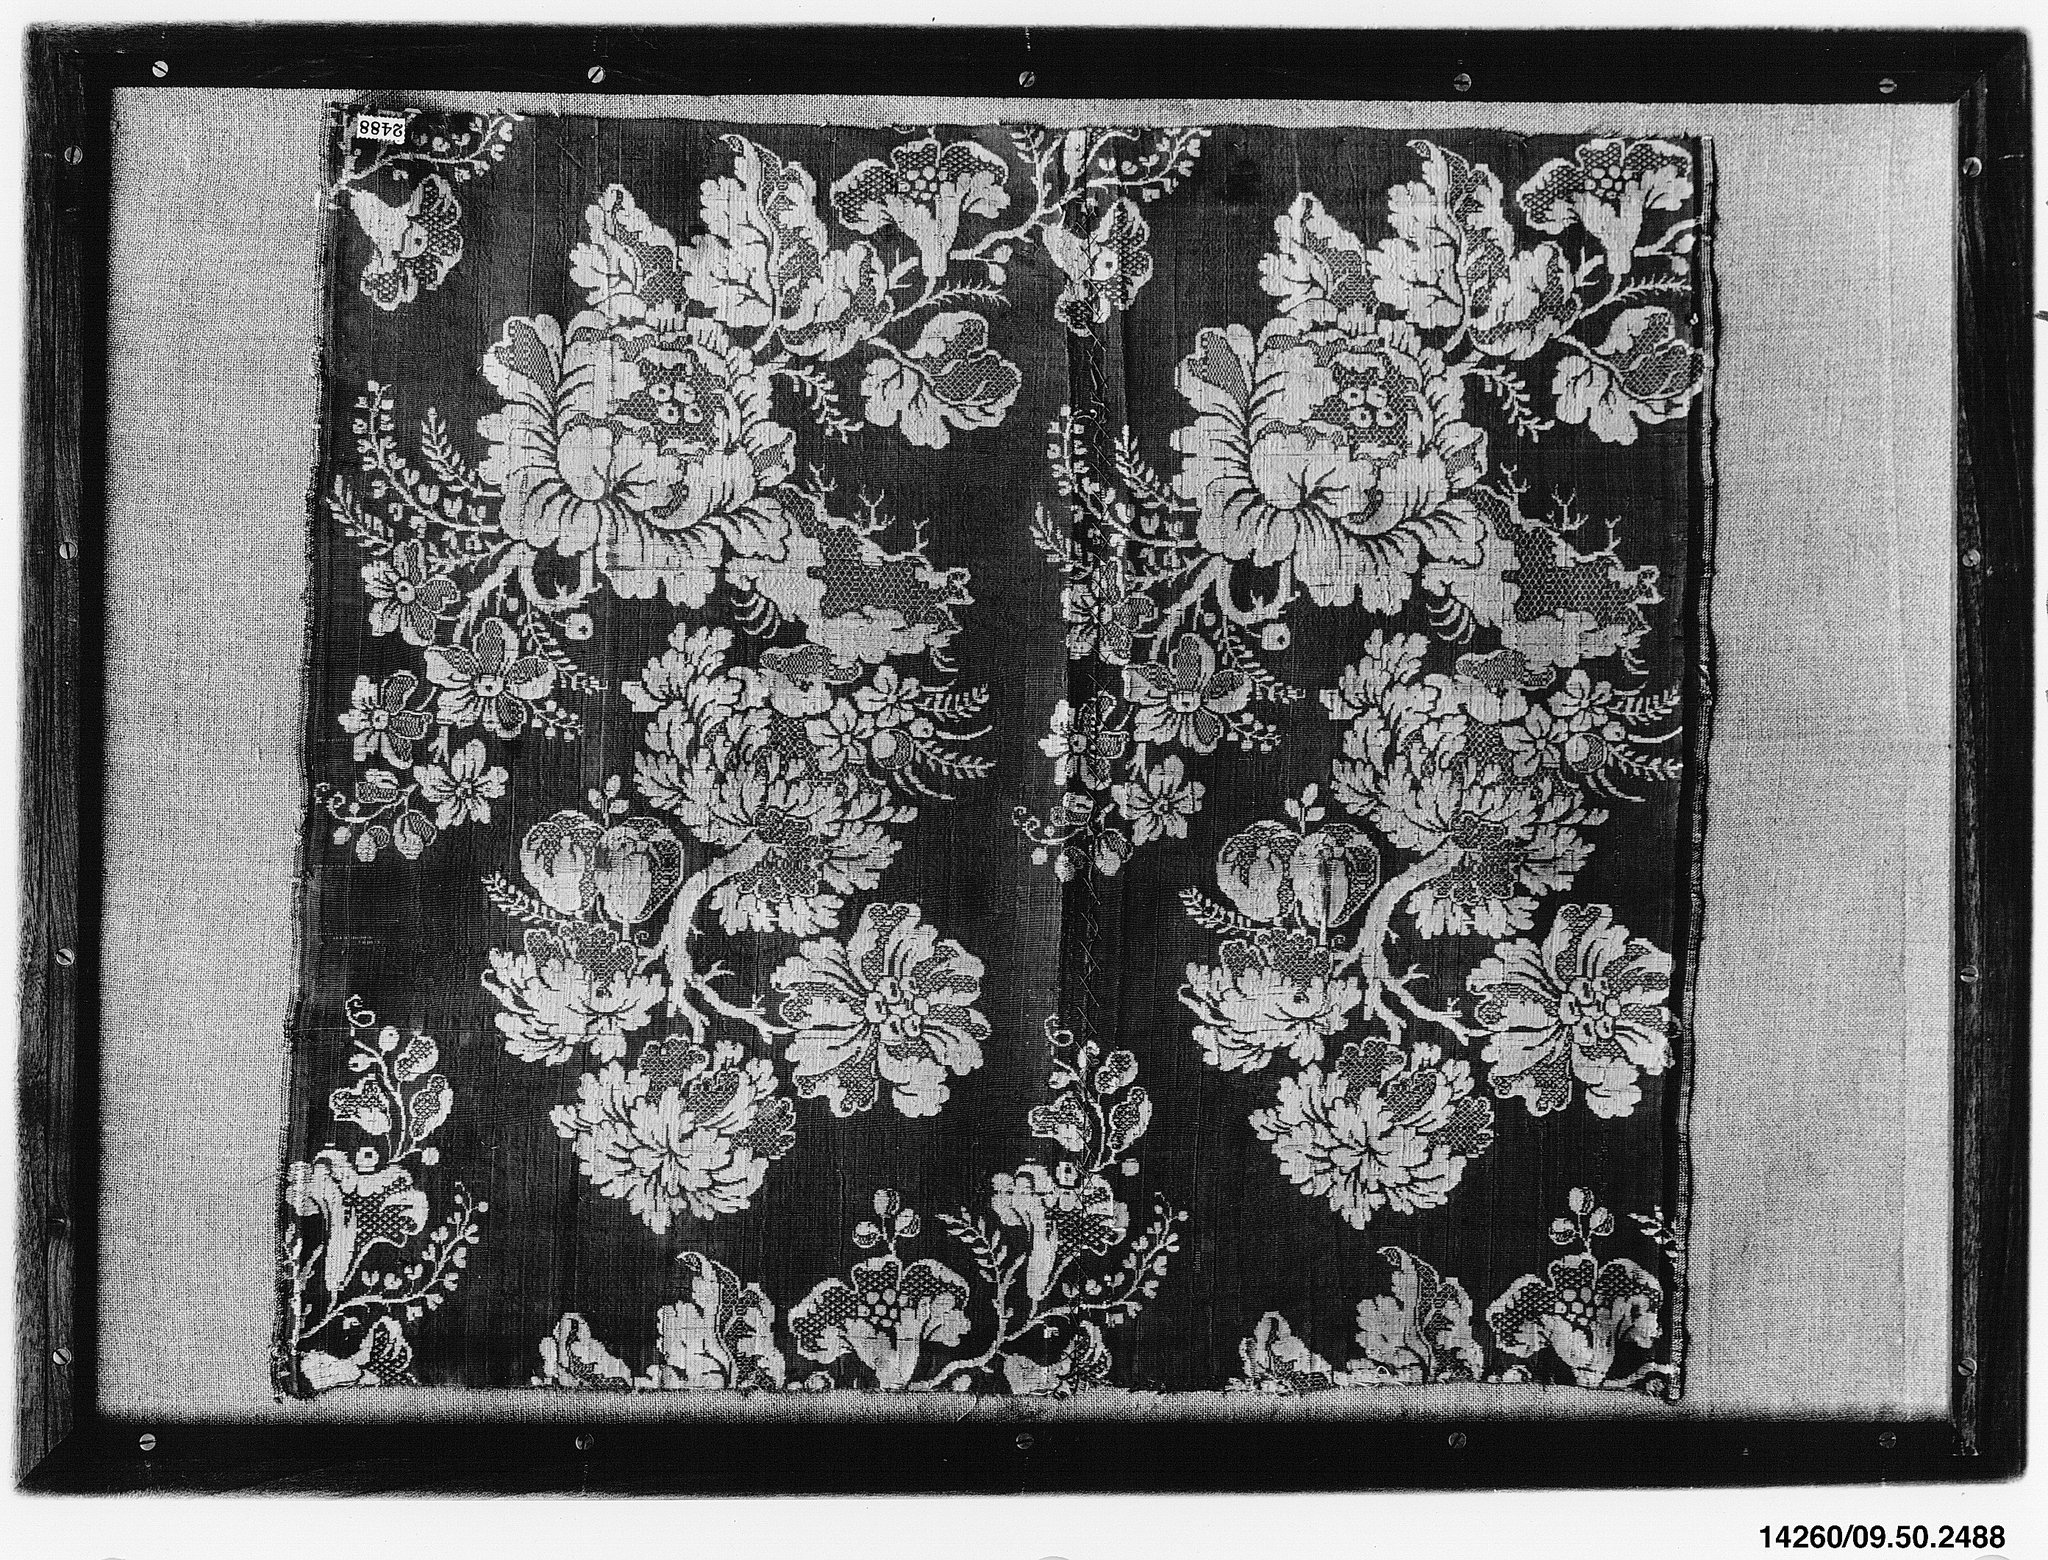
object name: piece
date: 1734-1766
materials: silk